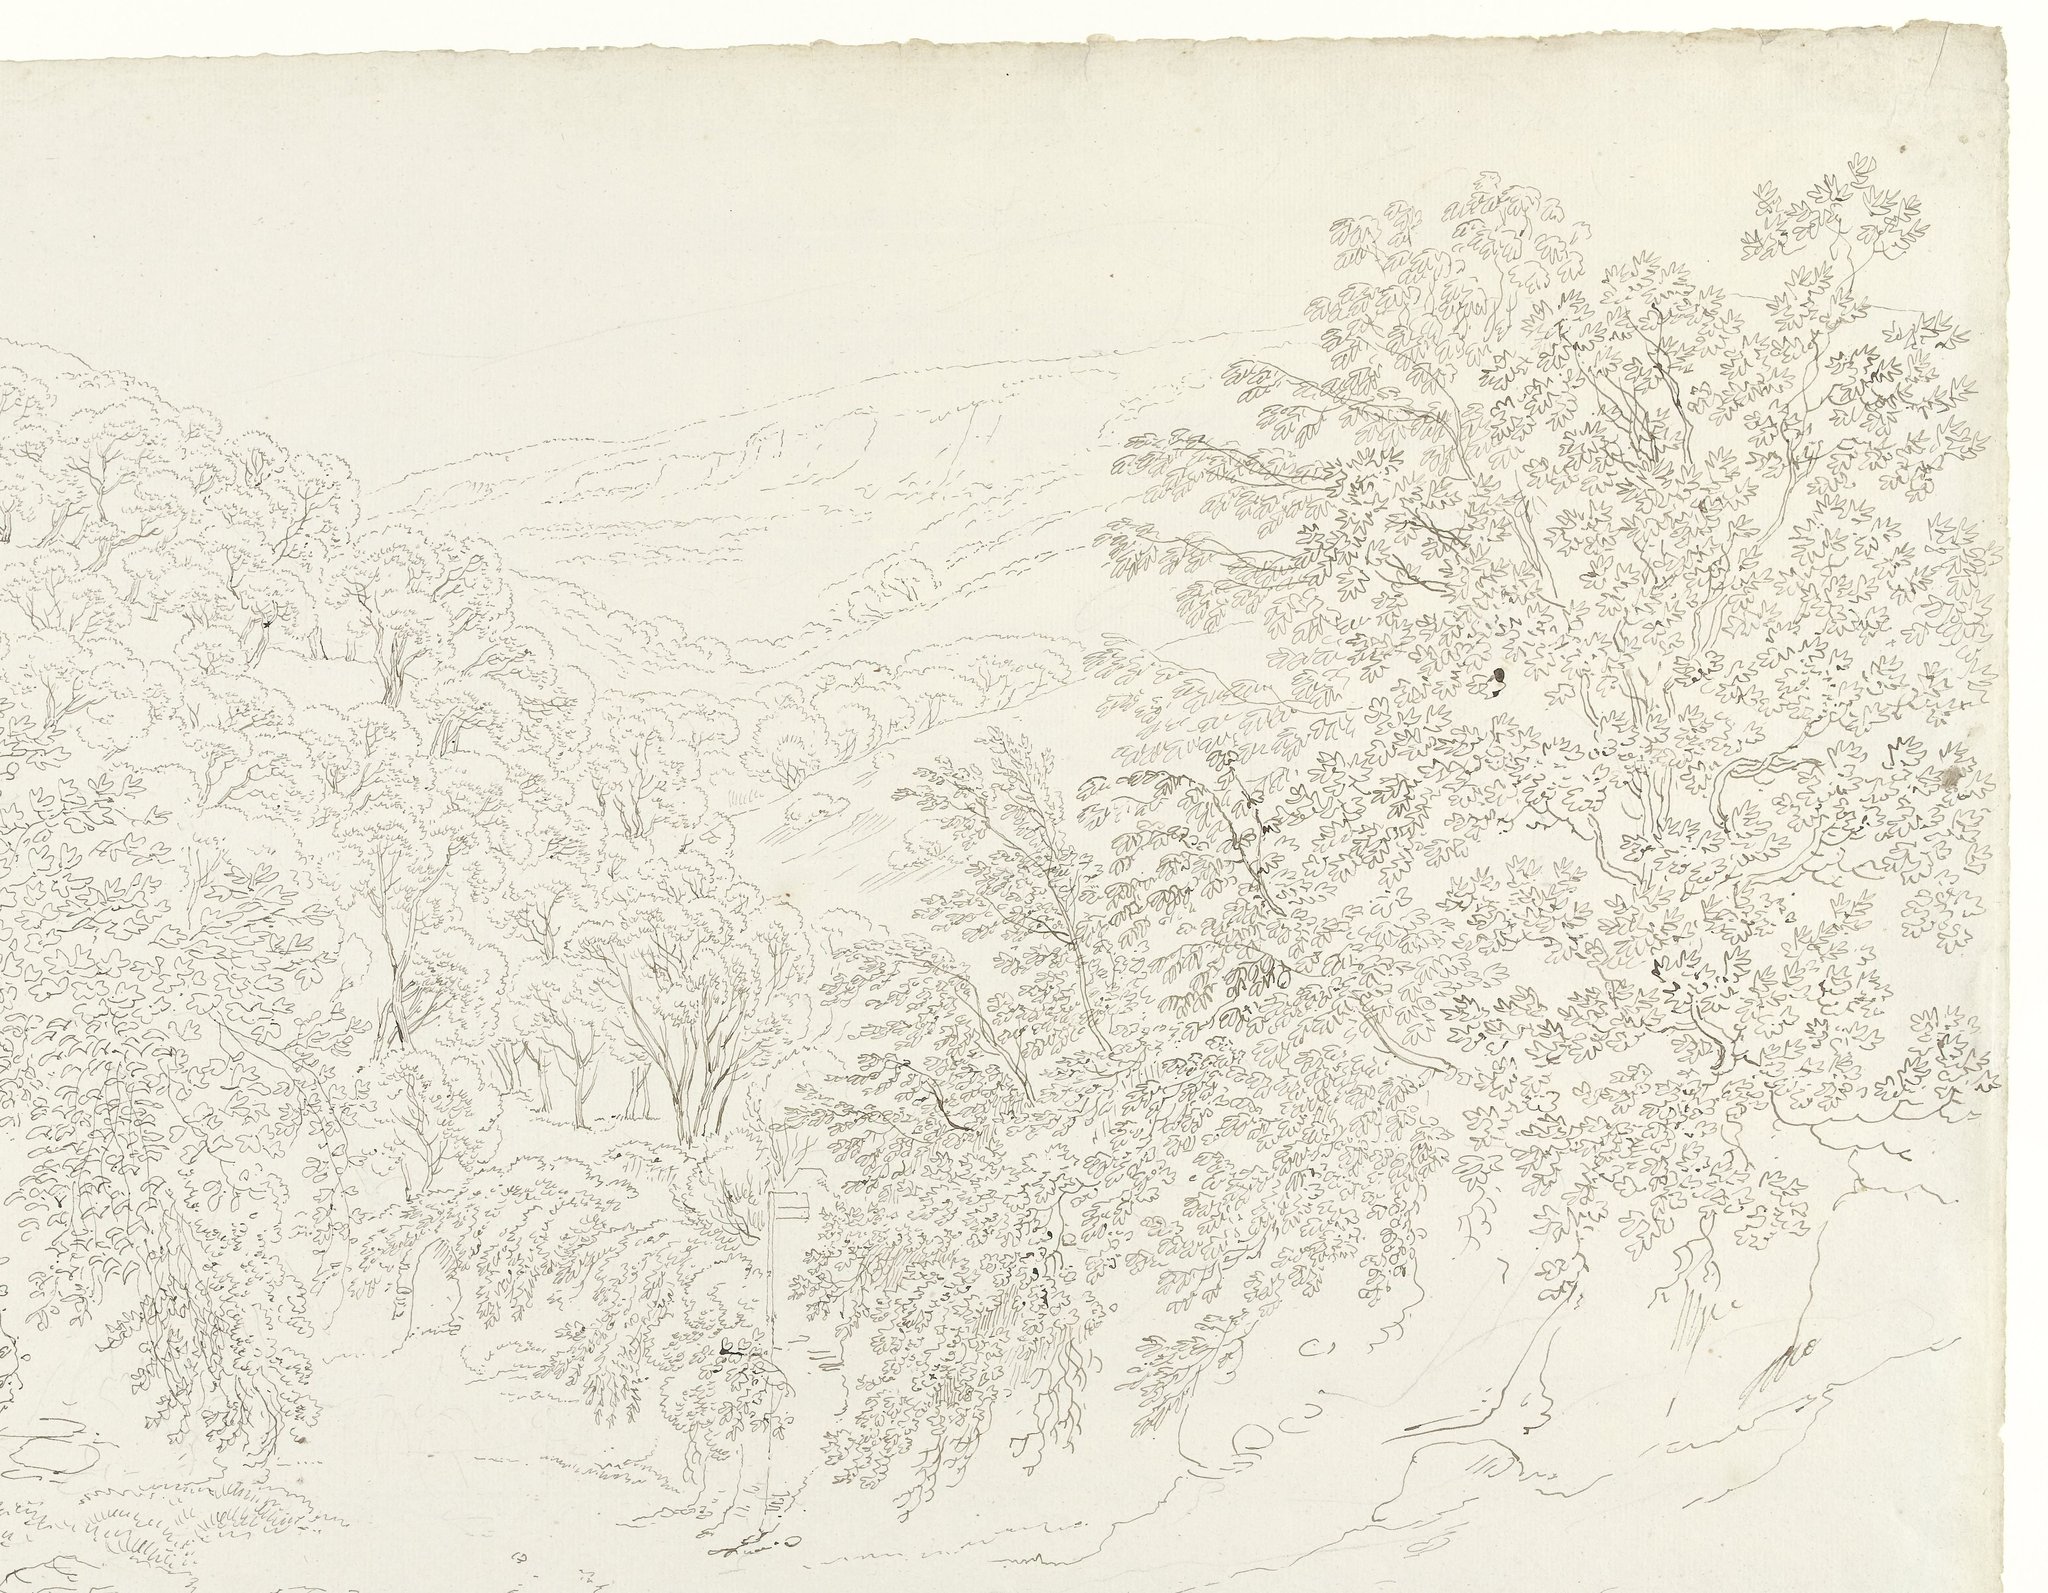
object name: drawing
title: Gezicht in een bebost dal in de Romeinse Campagna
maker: hendrik voogd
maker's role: draughtsman, painter, print maker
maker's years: 1768-1839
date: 1788-1839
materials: ink, paper, pencil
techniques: pen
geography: rome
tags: forest, wood, mountains, campania